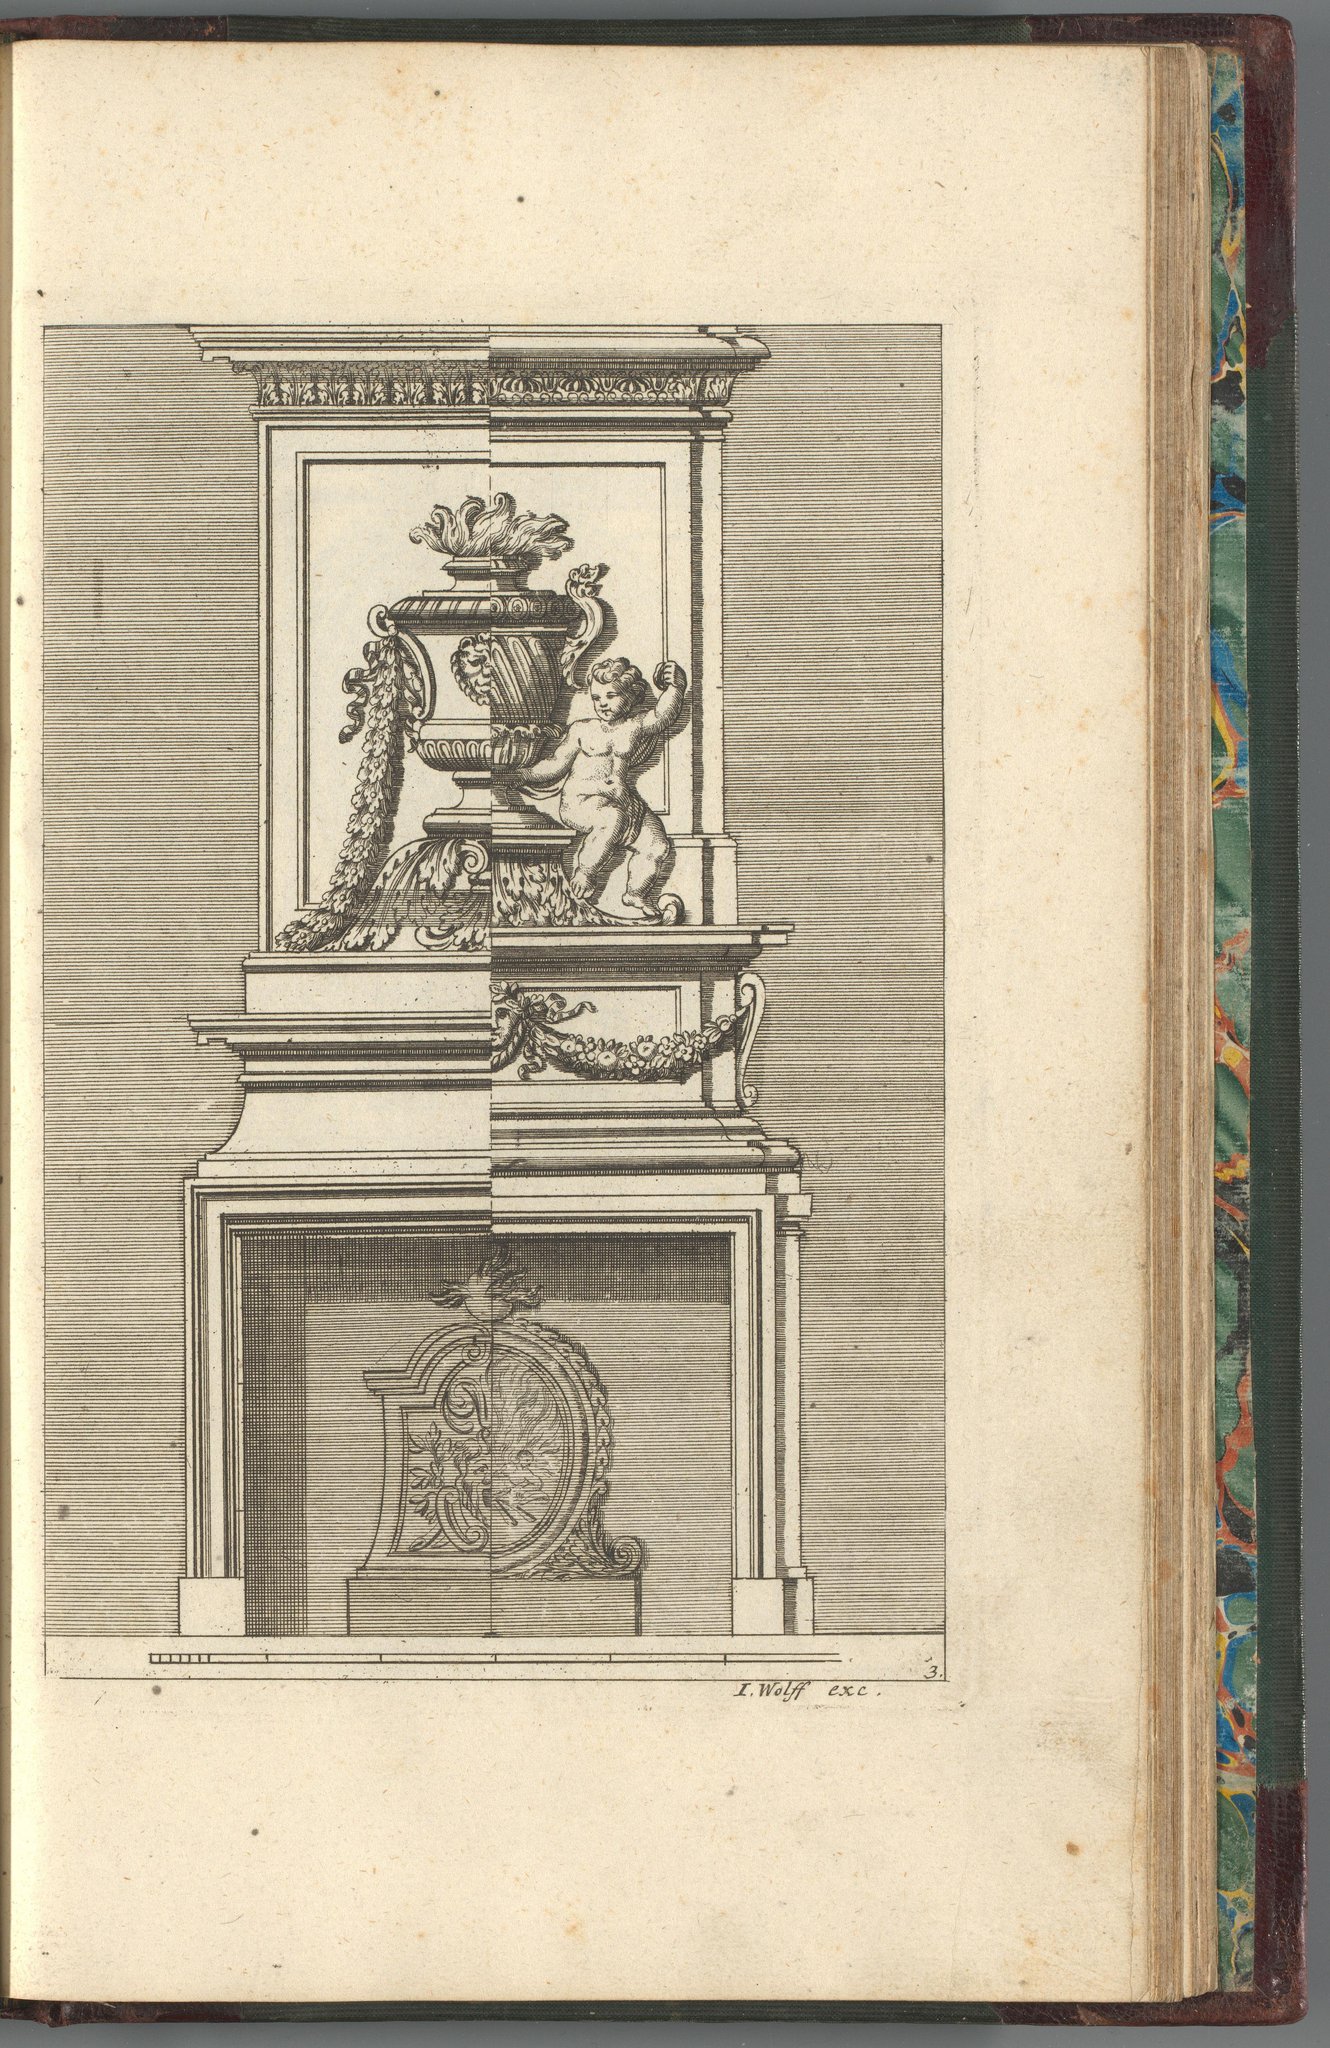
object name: print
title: Ontwerp van schoorsteenmantel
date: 1686-1724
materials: paper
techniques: etching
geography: augsburg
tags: ornaments ~ art, chimney-piece, mantelpiece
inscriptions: signature: ‘I. Wolff exc.’, number: ‘3.’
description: Ontwerp van een schoorsteenmantel met een grote urn met vlammen. Links ervan hangt een guirlande en rechts zit een putto. Derde prent uit een serie van zes. Prent maakt deel uit van een album. Hoogstwaarschijnlijk kopie naar Frans origineel.